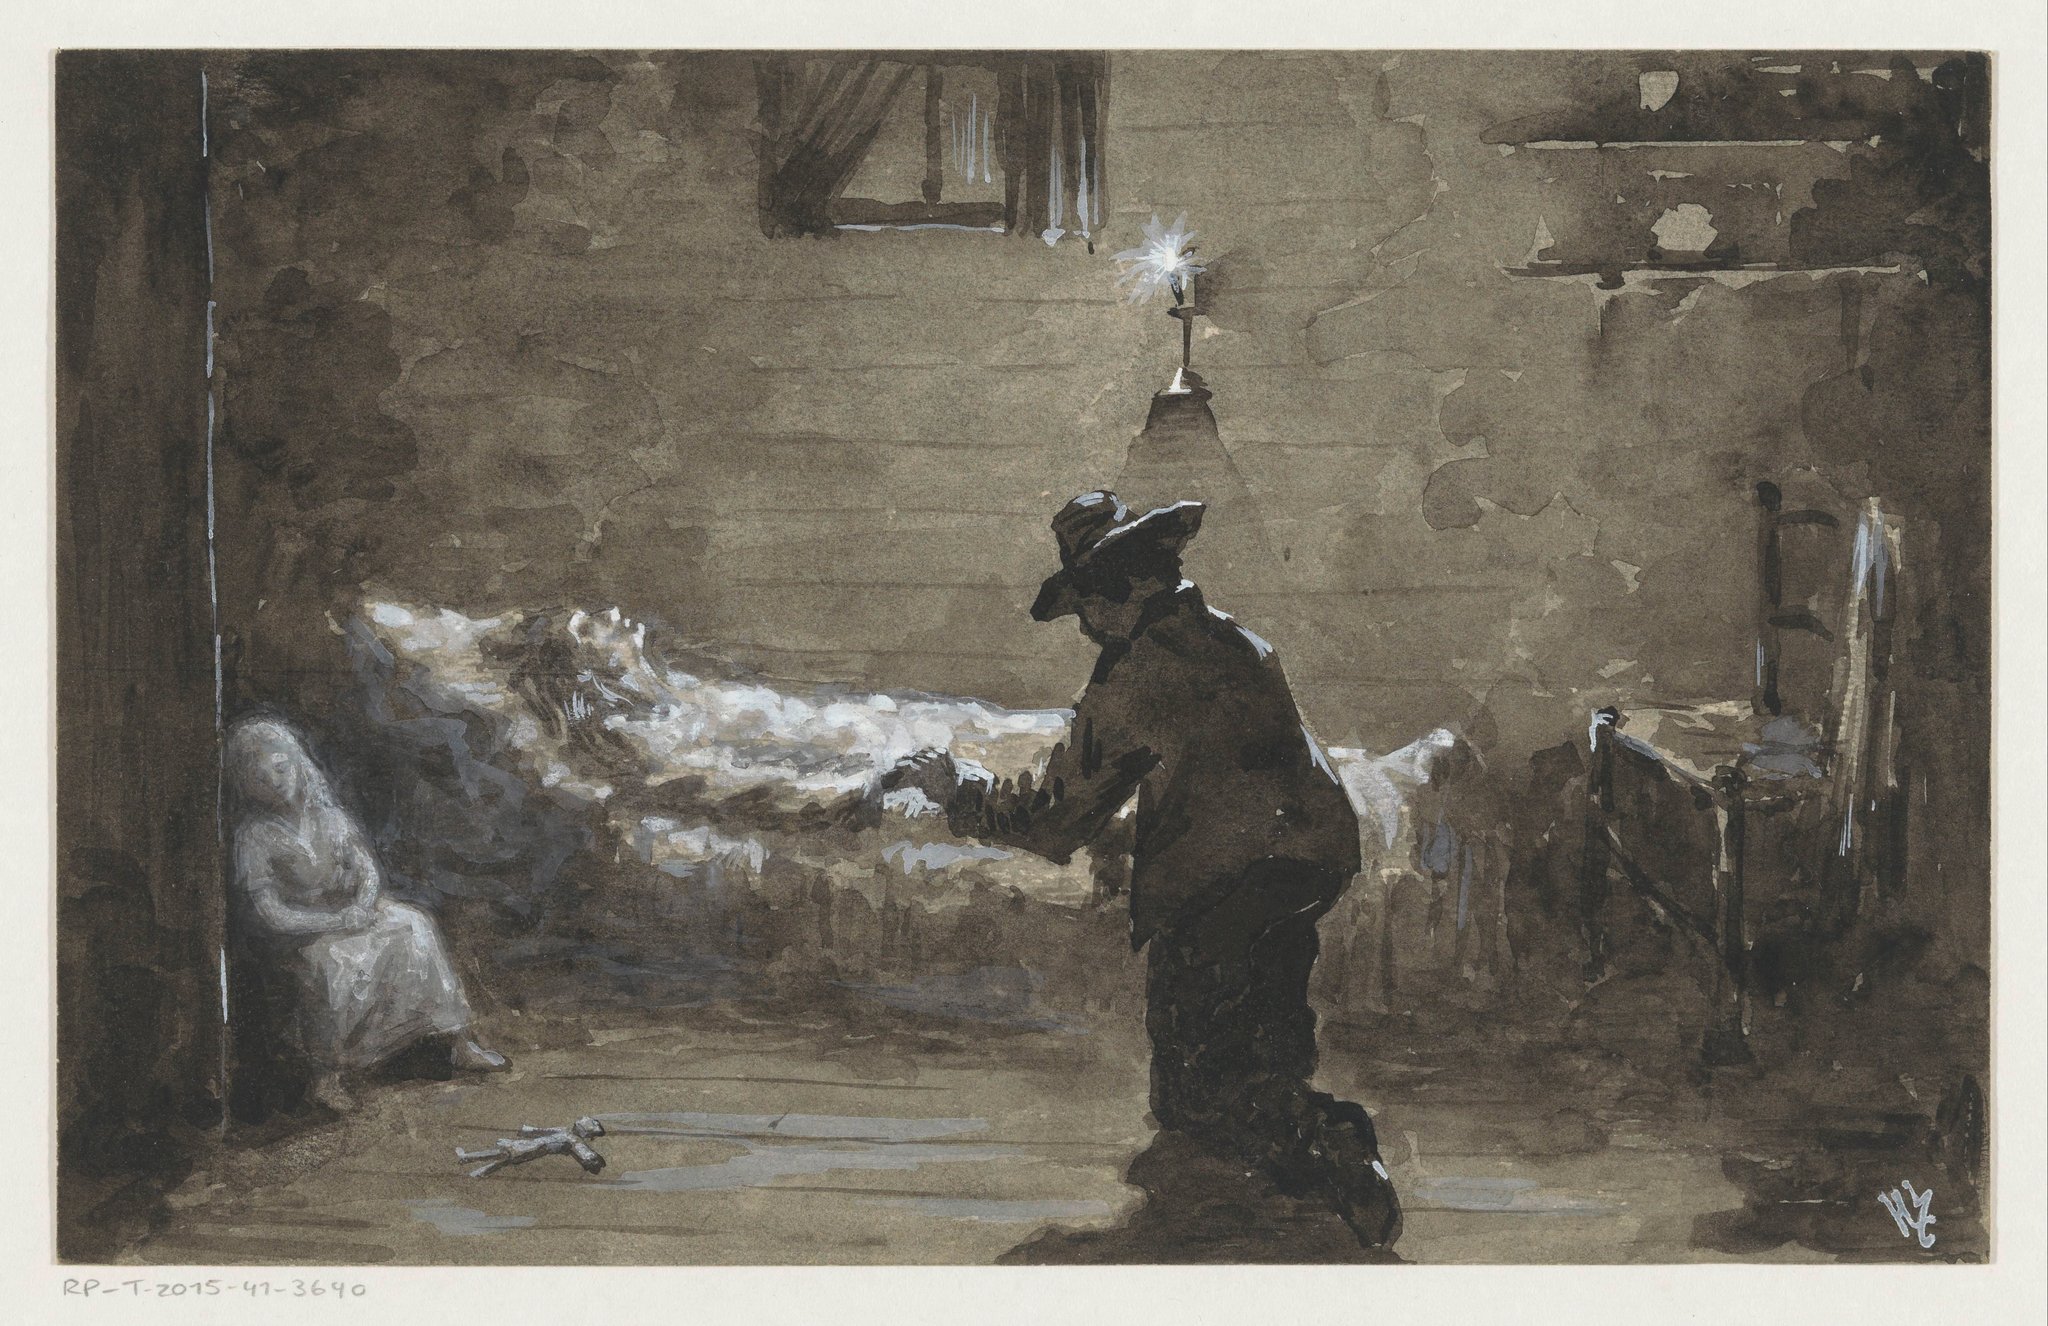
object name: drawing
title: Man knielt bij het bed van een vrouw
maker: h.c. louwerse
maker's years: 1878-1946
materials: paint, paper, pencil, watercolor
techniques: brush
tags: deathbed, kneeling figure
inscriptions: monogram: ‘HCL’, annotation: ‘Toen bij 't bed van de directrice gekomen, deed hij de/ [...] nog eens, die hij daar even deed, nam haar hand,/ maar liet deze onmiddelijk loodzwaar weer/ neervallen (Bladz 22)’, collector's mark: Lugt 2228a, :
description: In een door kaarslicht verlicht vertrek knielt een man bij het bed van een vrouw. De vrouw is vermoedelijk stervende. In een hoek zit een meisje. Voor haar ligt een pop op de grond.